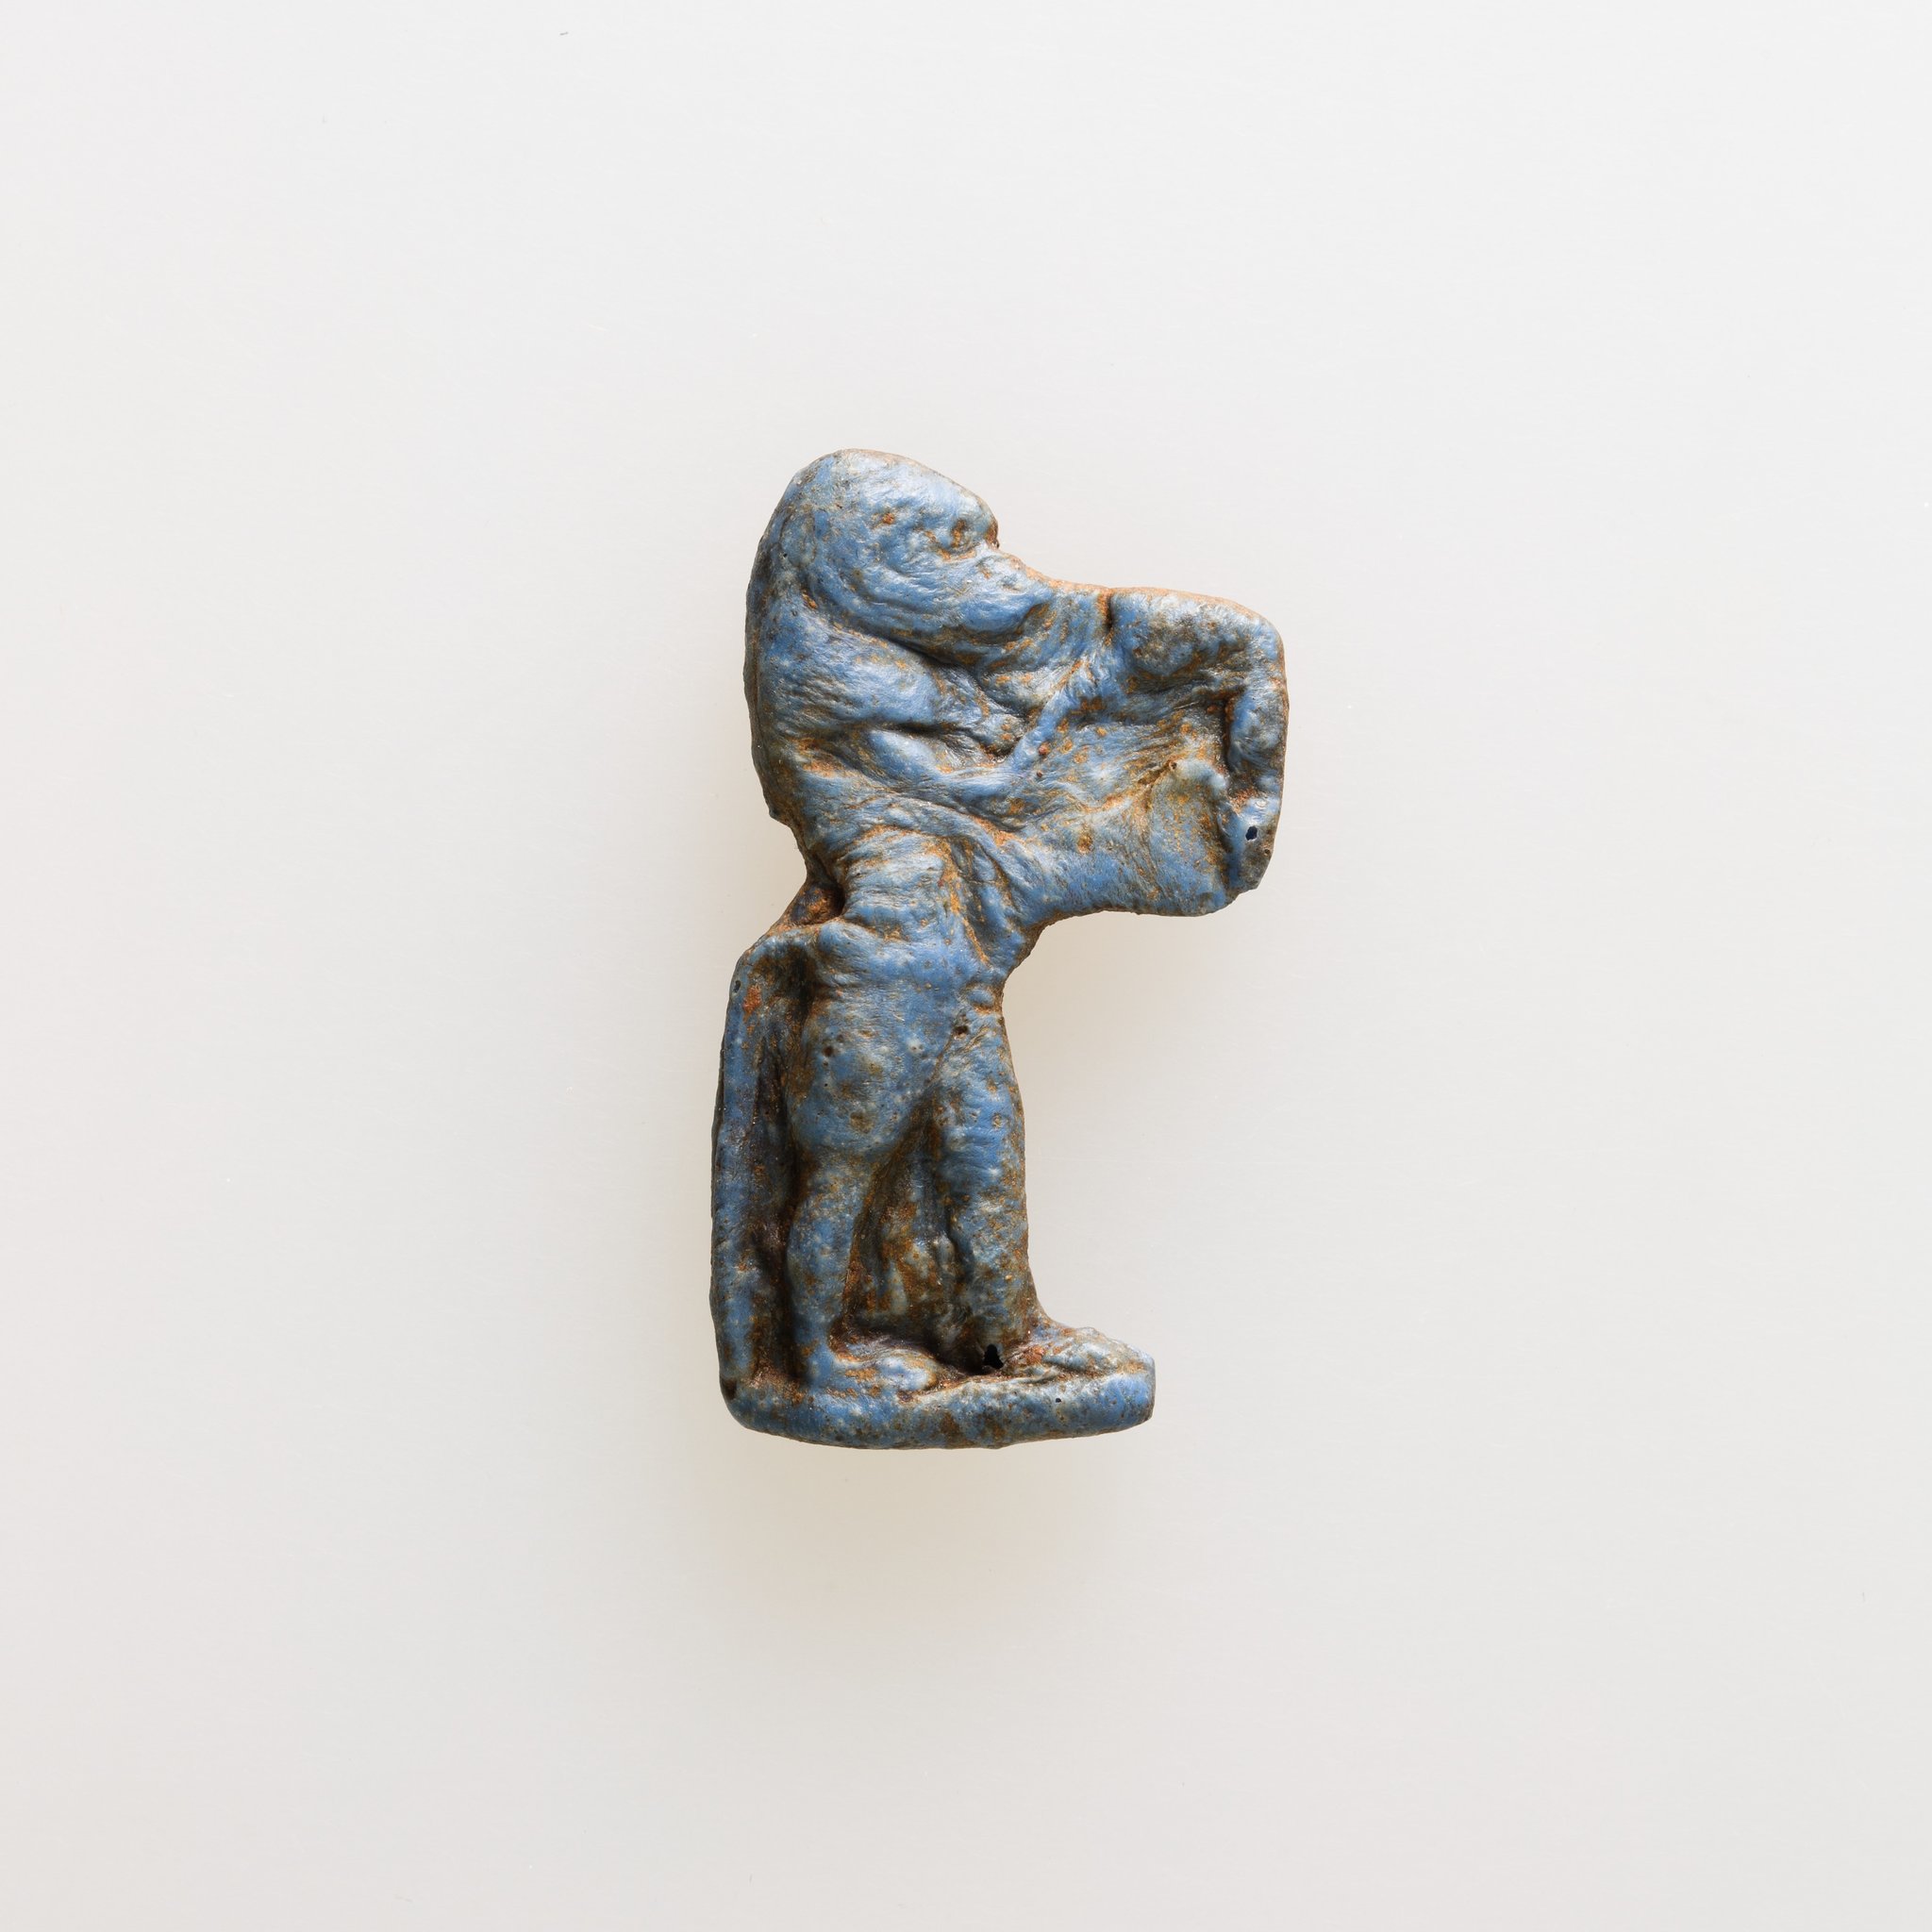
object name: amulet, baboon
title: Amulet of a baboon holding an unrecognizable object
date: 525-30 BCE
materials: glass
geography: egypt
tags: baboons